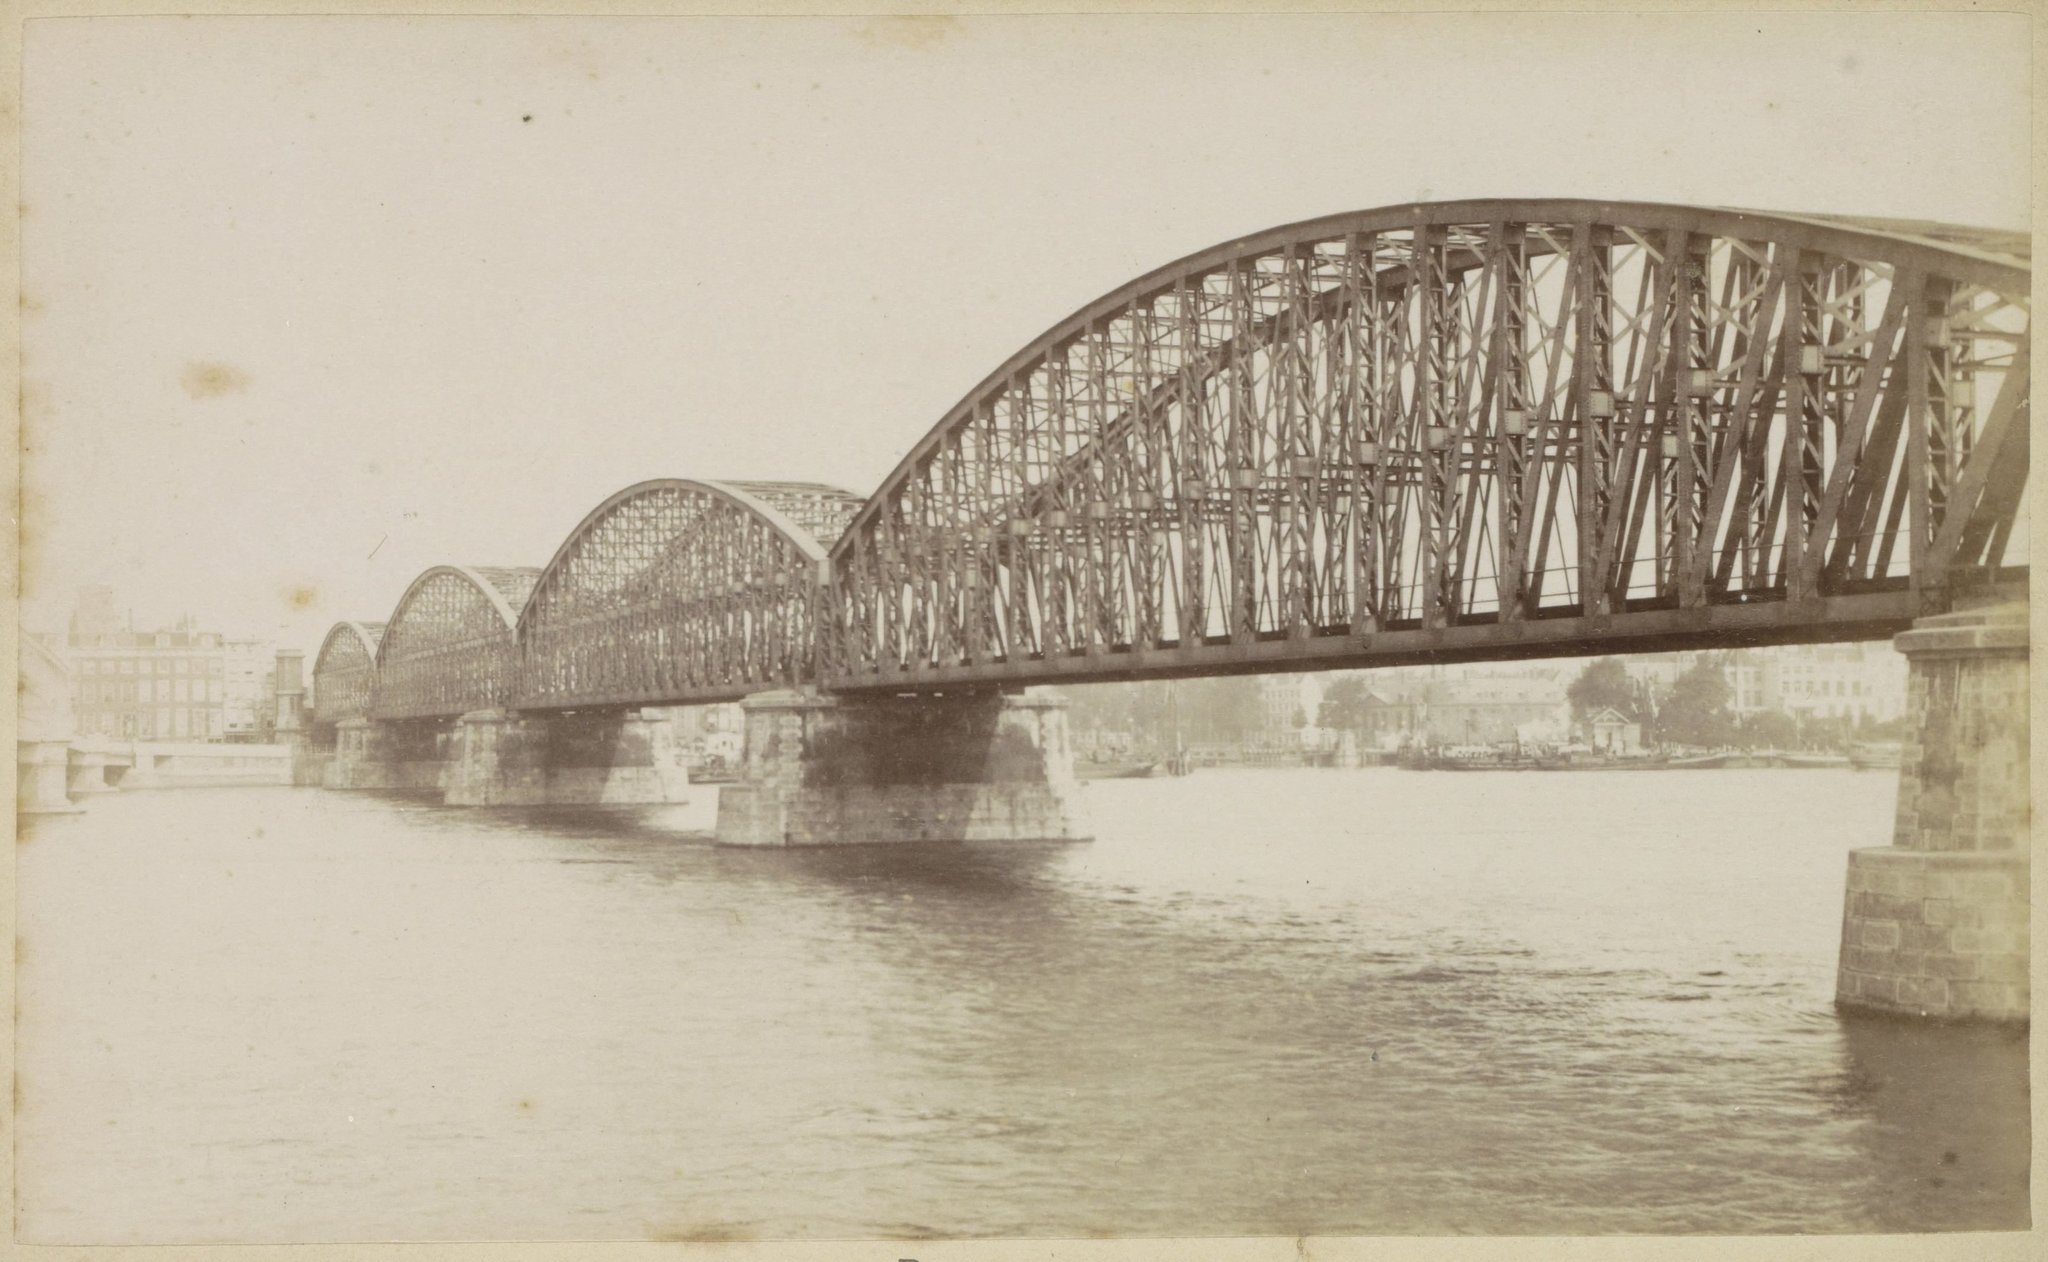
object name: cabinet photograph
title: De spoorbrug over de Maas. Rotterdam.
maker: andries jager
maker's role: publisher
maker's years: 1825-1905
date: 1877-1900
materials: cardboard, photographic support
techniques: albumen print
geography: rotterdam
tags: bridge in city across river, canal, etc., rotterdam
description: Onderdeel van Leporelloalbum met foto's van Rotterdam.